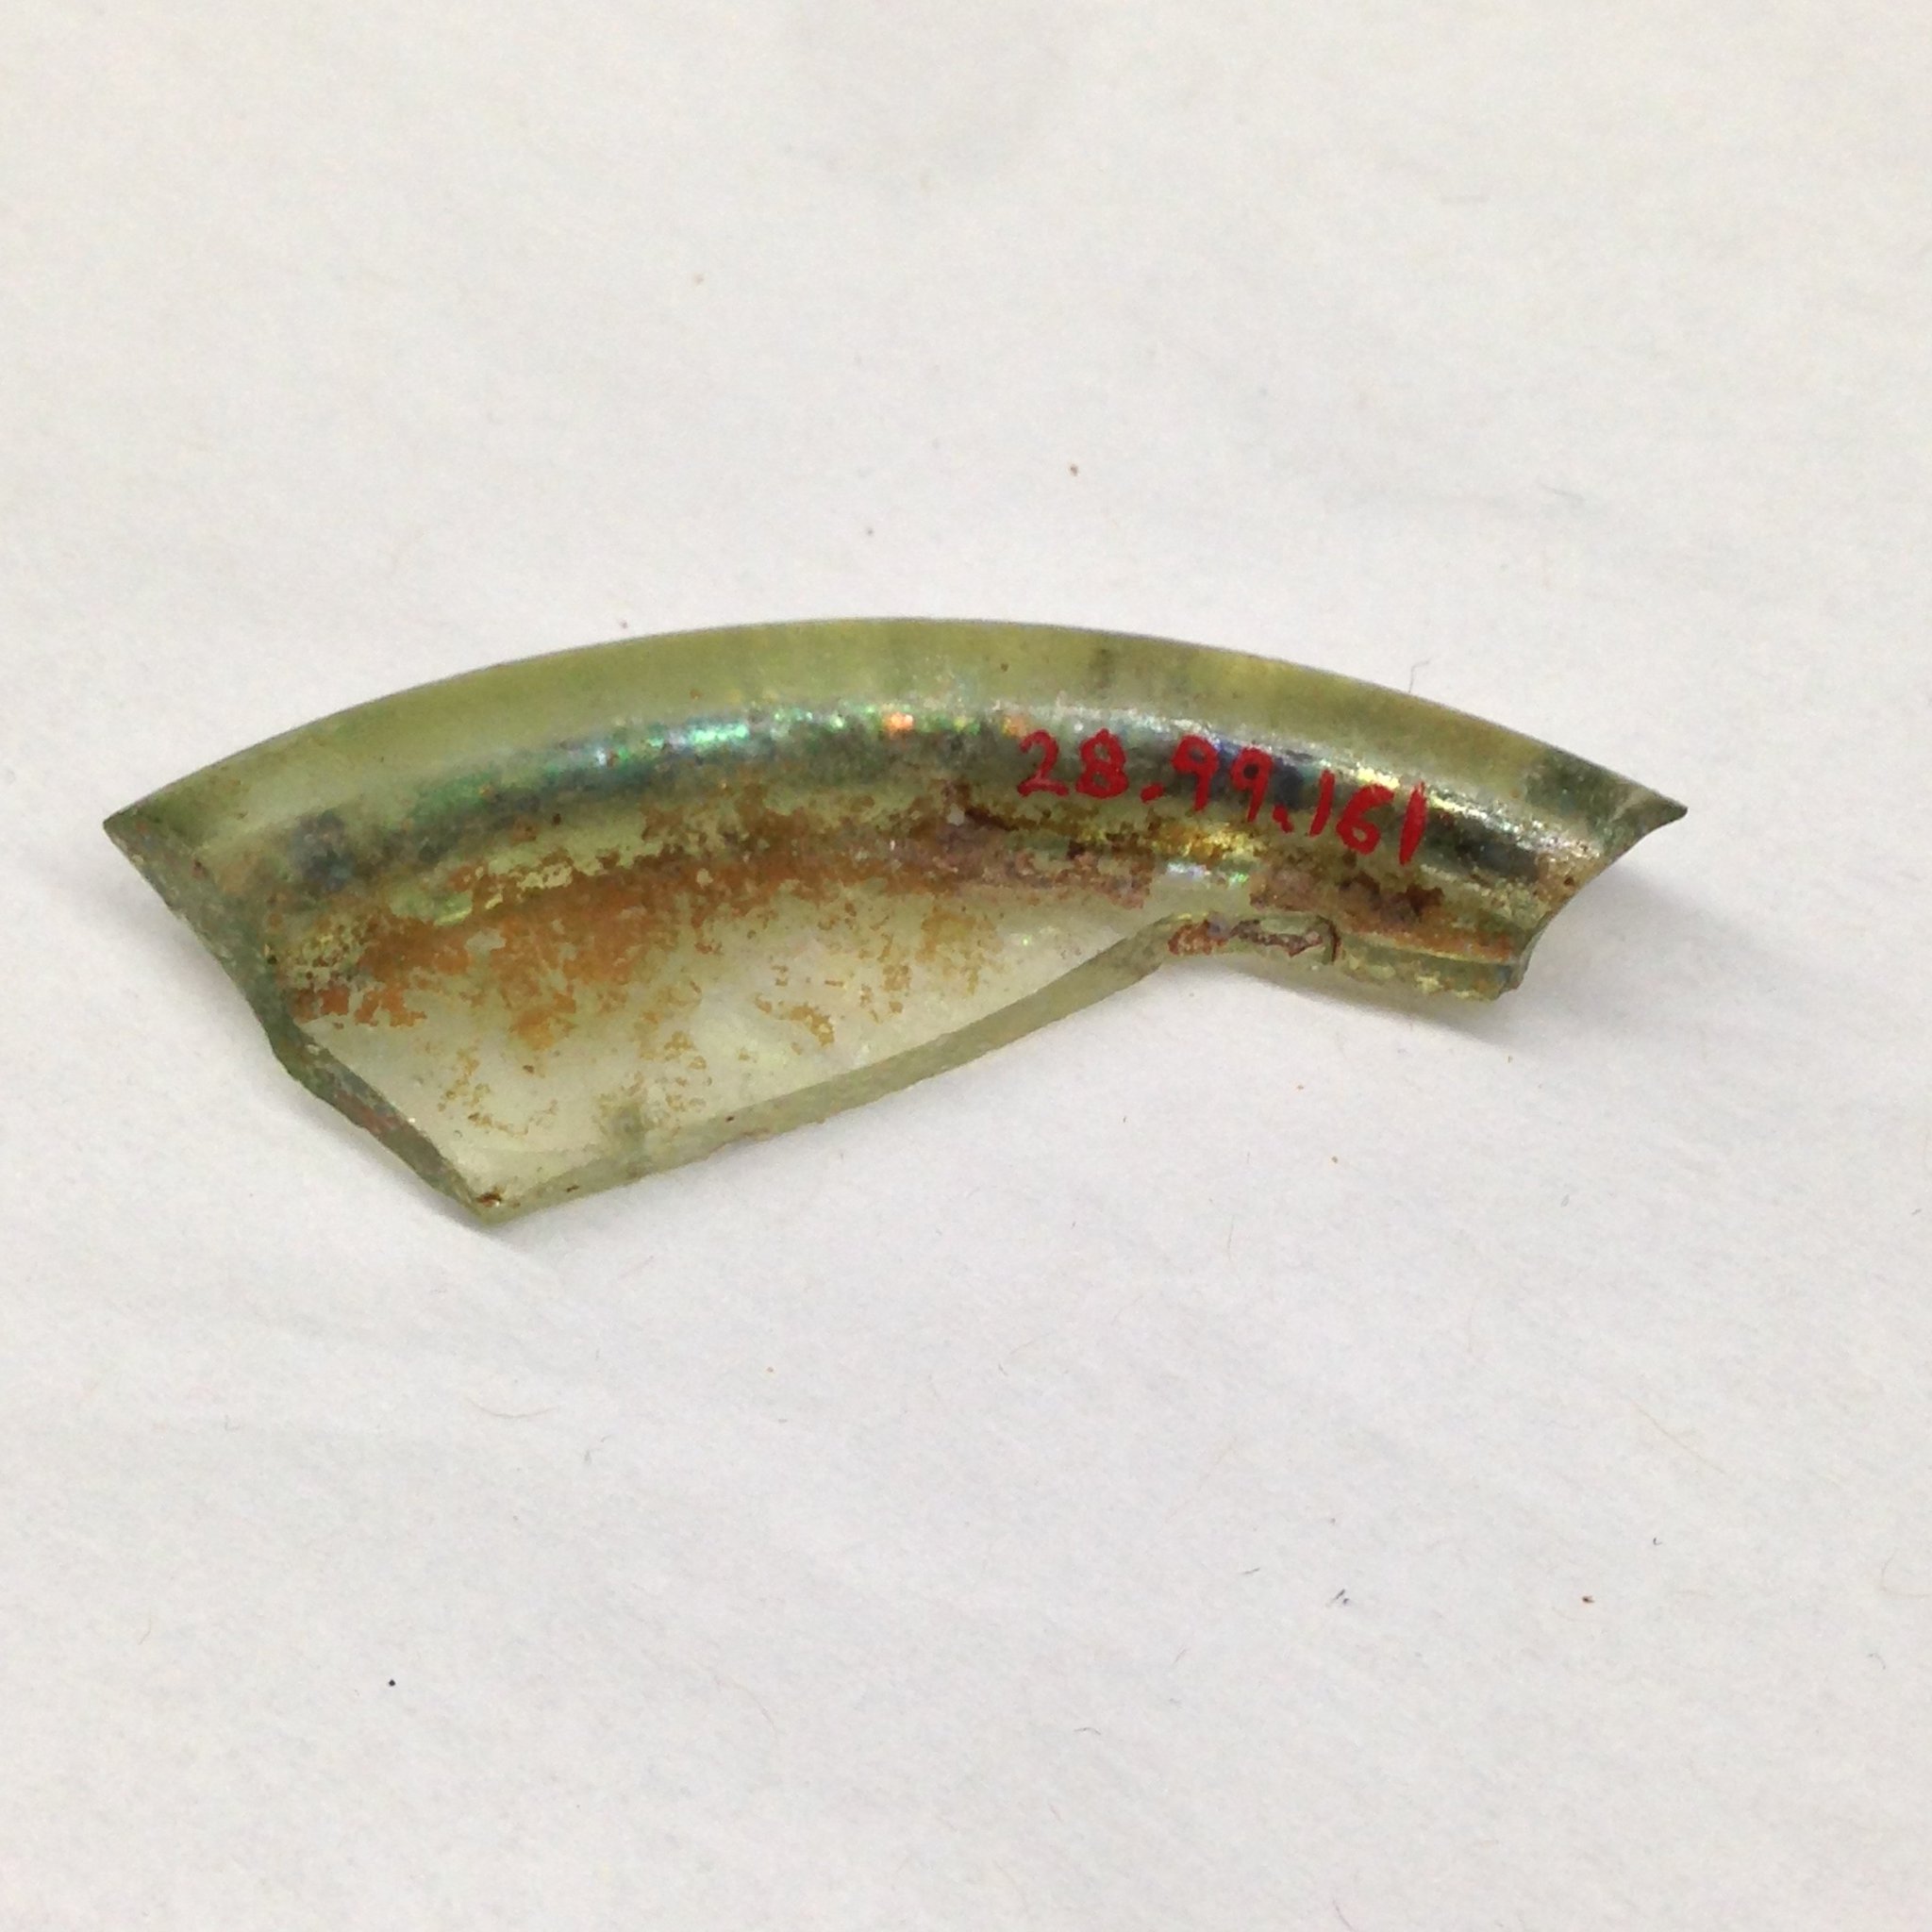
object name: fragment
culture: european or middle eastern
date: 1150-1250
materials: ceramic, glass